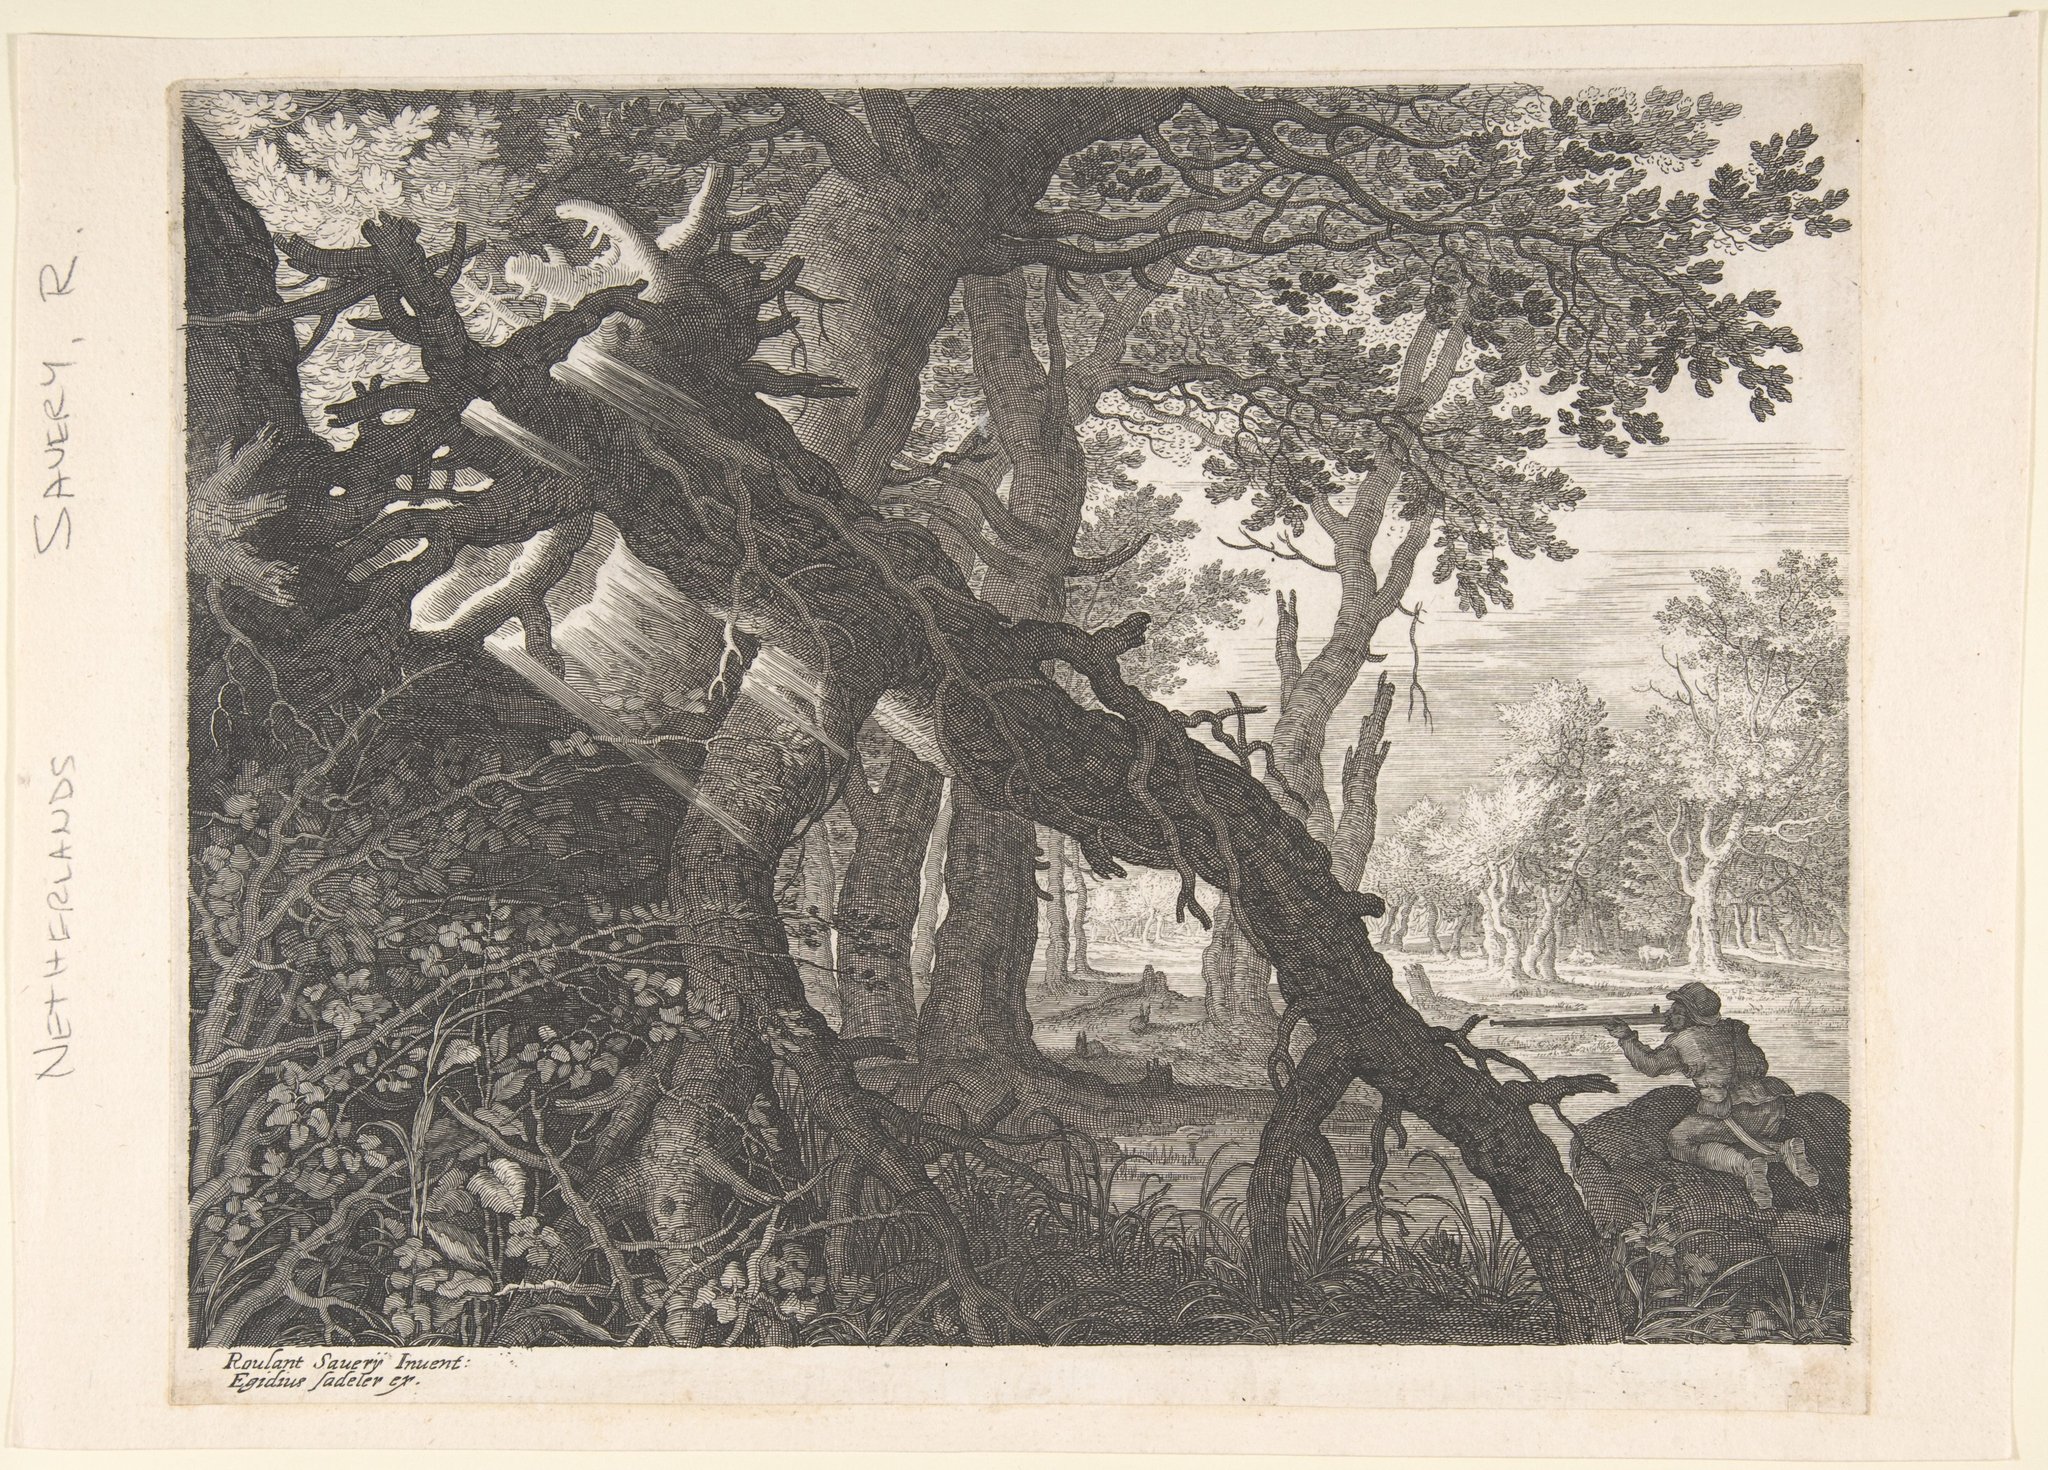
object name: print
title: A Forest with a Rabbit Hunt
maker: aegidius sadeler (ii)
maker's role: artist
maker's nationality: flemish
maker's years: 1568-1629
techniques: engraving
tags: men,hunting,forests